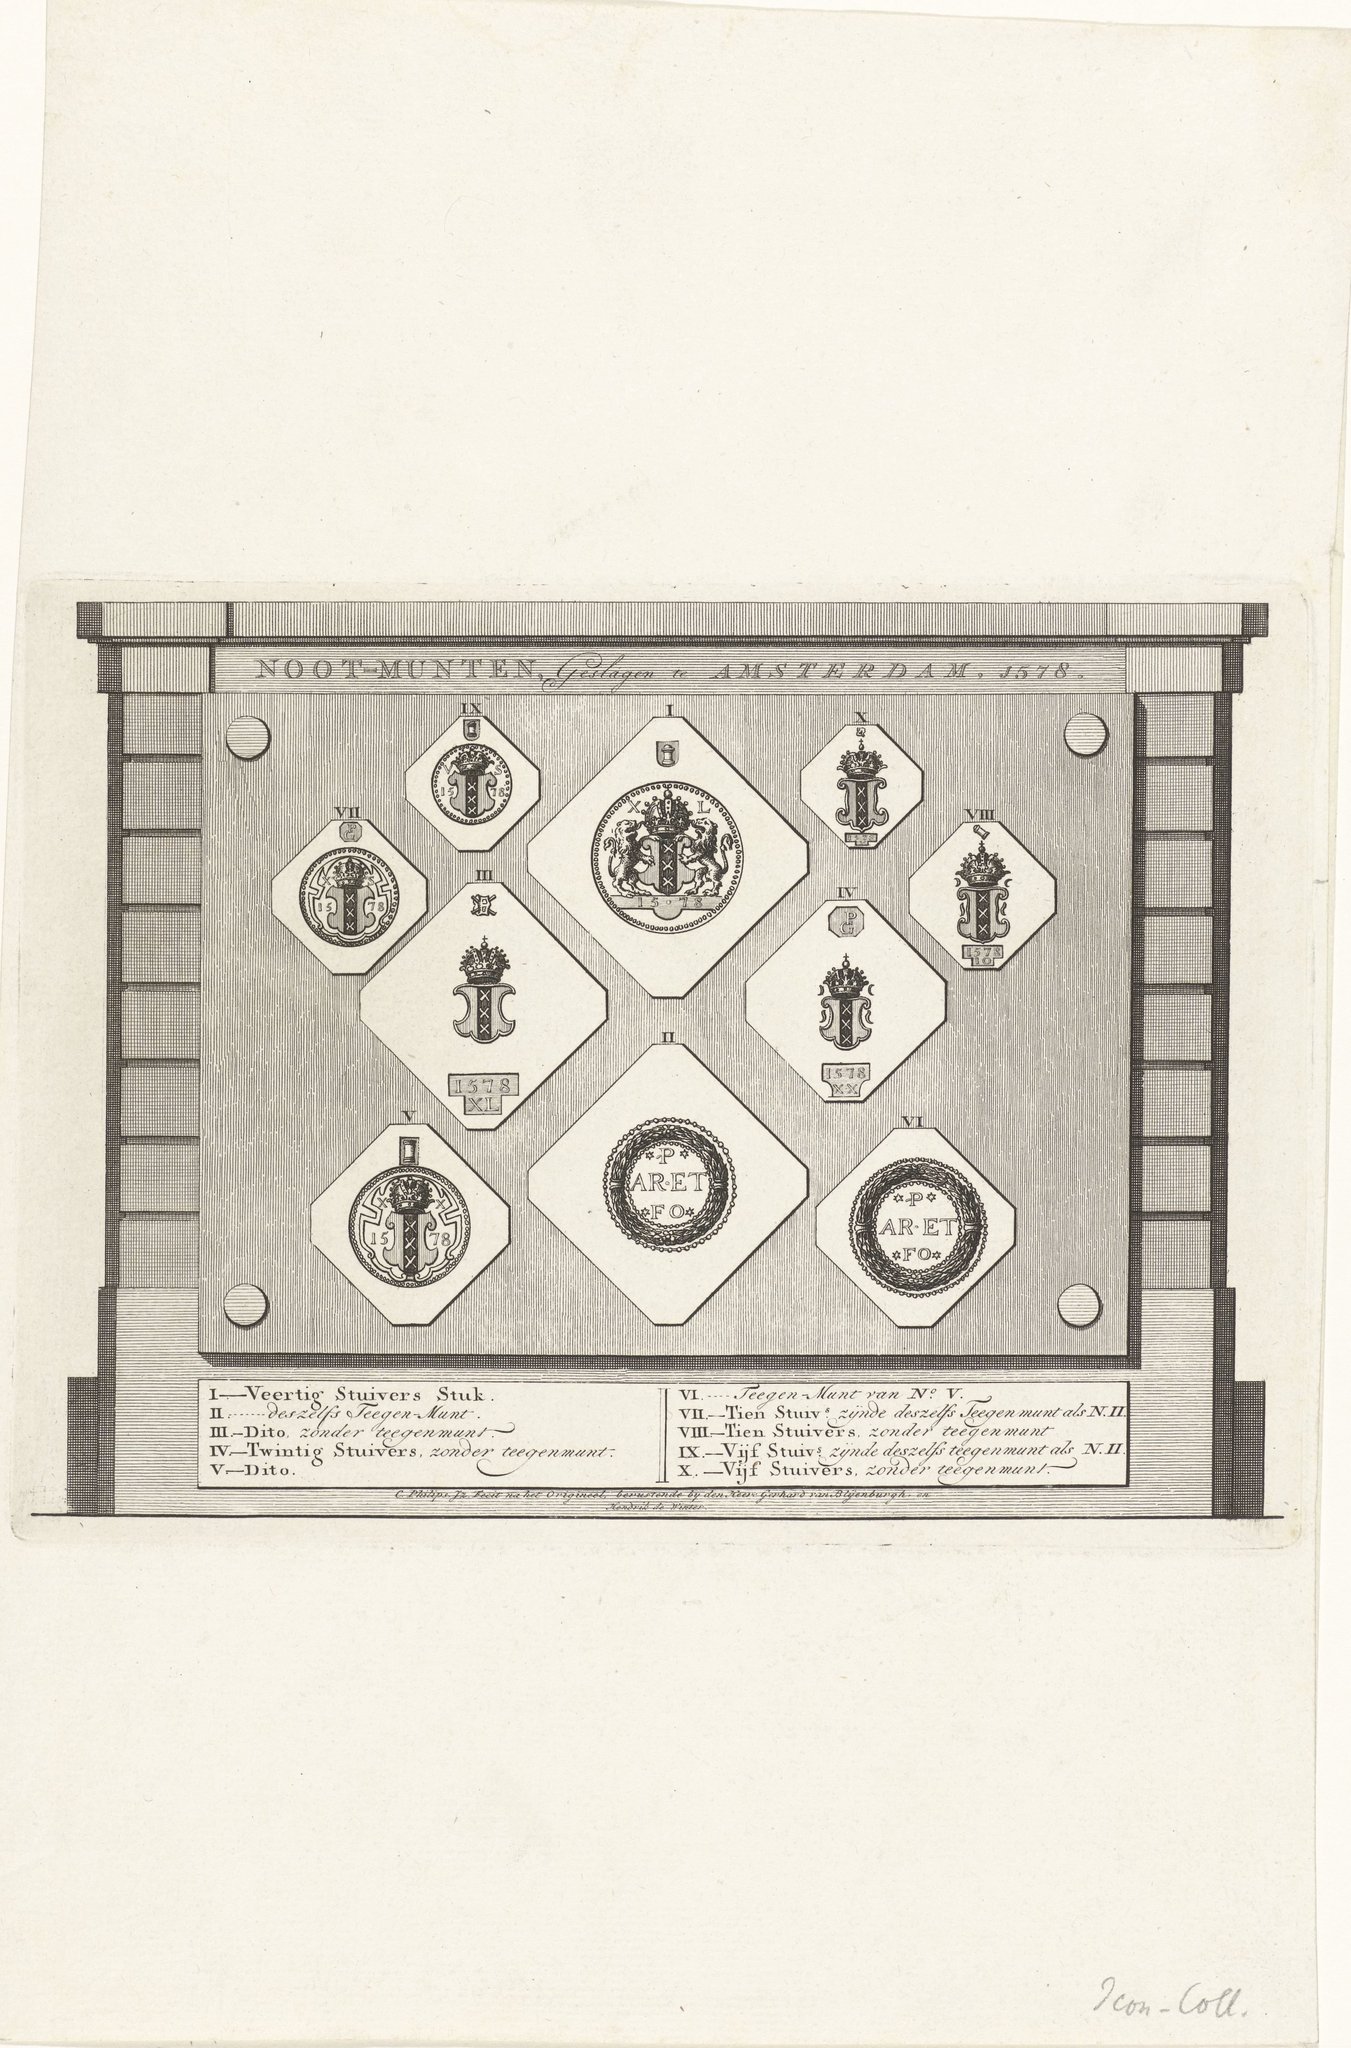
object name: print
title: Noodmunten uit Amsterdam, 1578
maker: caspar jacobsz. philips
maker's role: draughtsman, print maker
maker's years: 1732-1789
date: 1752-1789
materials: paper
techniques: engraving, etching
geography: amsterdam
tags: coin, amsterdam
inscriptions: collector's mark: Lugt 2228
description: Volgens Muller gebruikt als illustratie in Wagenaars geschiedenis van Amsterdam. Dit lijkt niet te kloppen. Voor eerste bekende staat zie RP-P-OB-79.747.